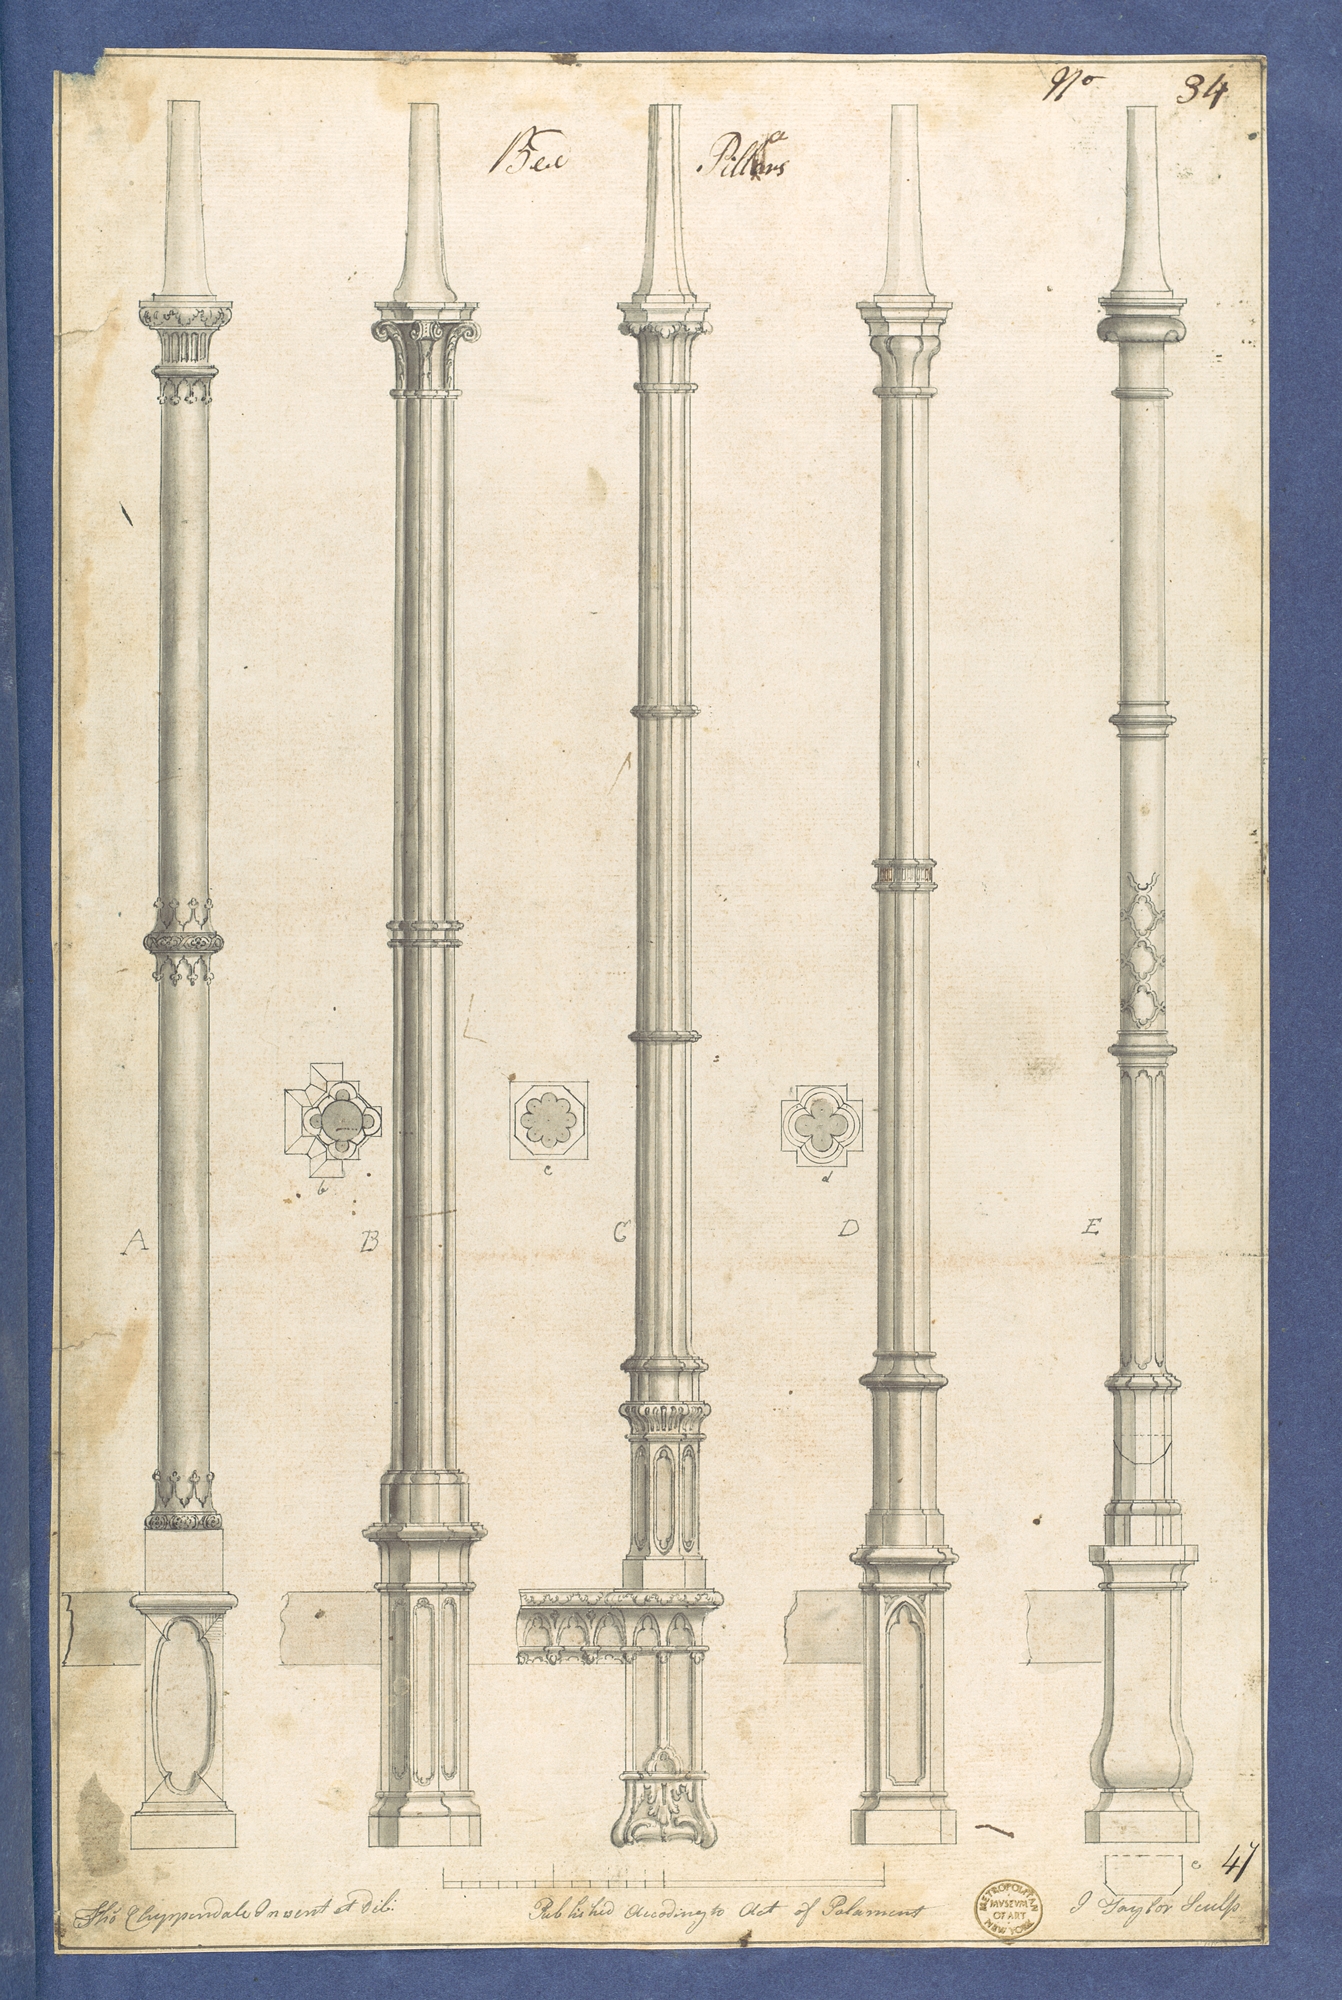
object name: drawing ornament architecture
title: Bed Pillars, in Chippendale Drawings, Vol. I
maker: thomas chippendale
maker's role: artist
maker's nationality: british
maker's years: 1718-1779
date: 1759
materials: ink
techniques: wash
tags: furniture